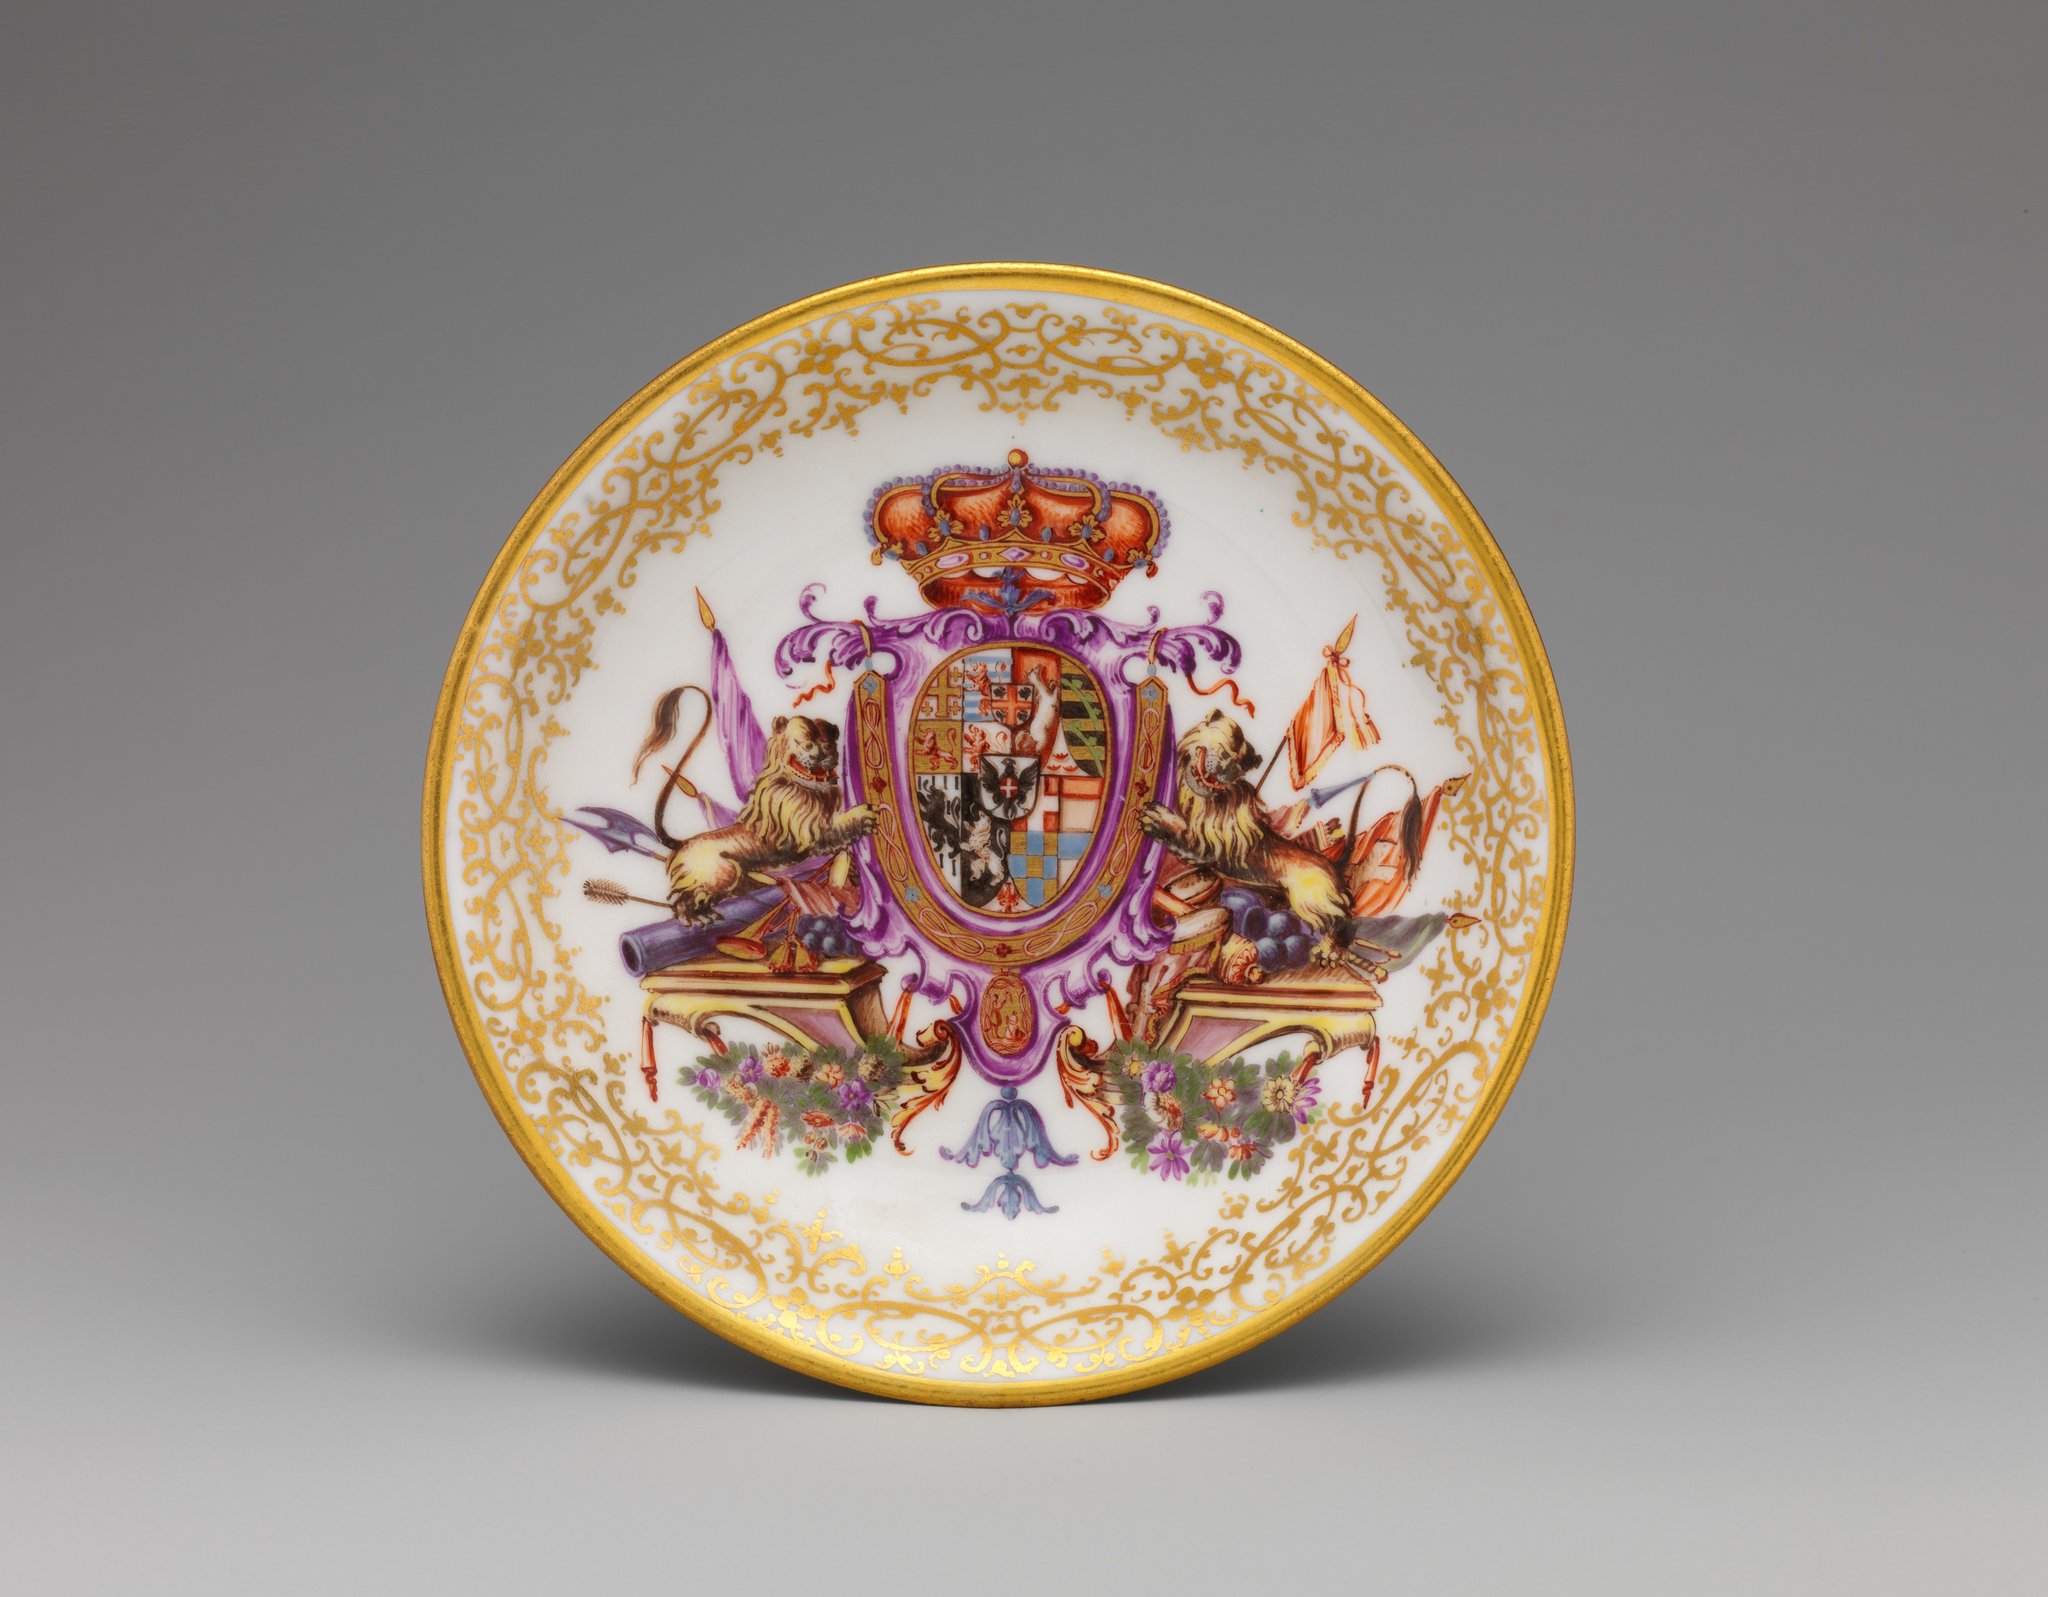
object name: saucer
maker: meissen manufactory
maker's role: manufactory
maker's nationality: german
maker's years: 1710-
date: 1724-1725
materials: enamel, gold, hard paste porcelain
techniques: polychrome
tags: coat of arms